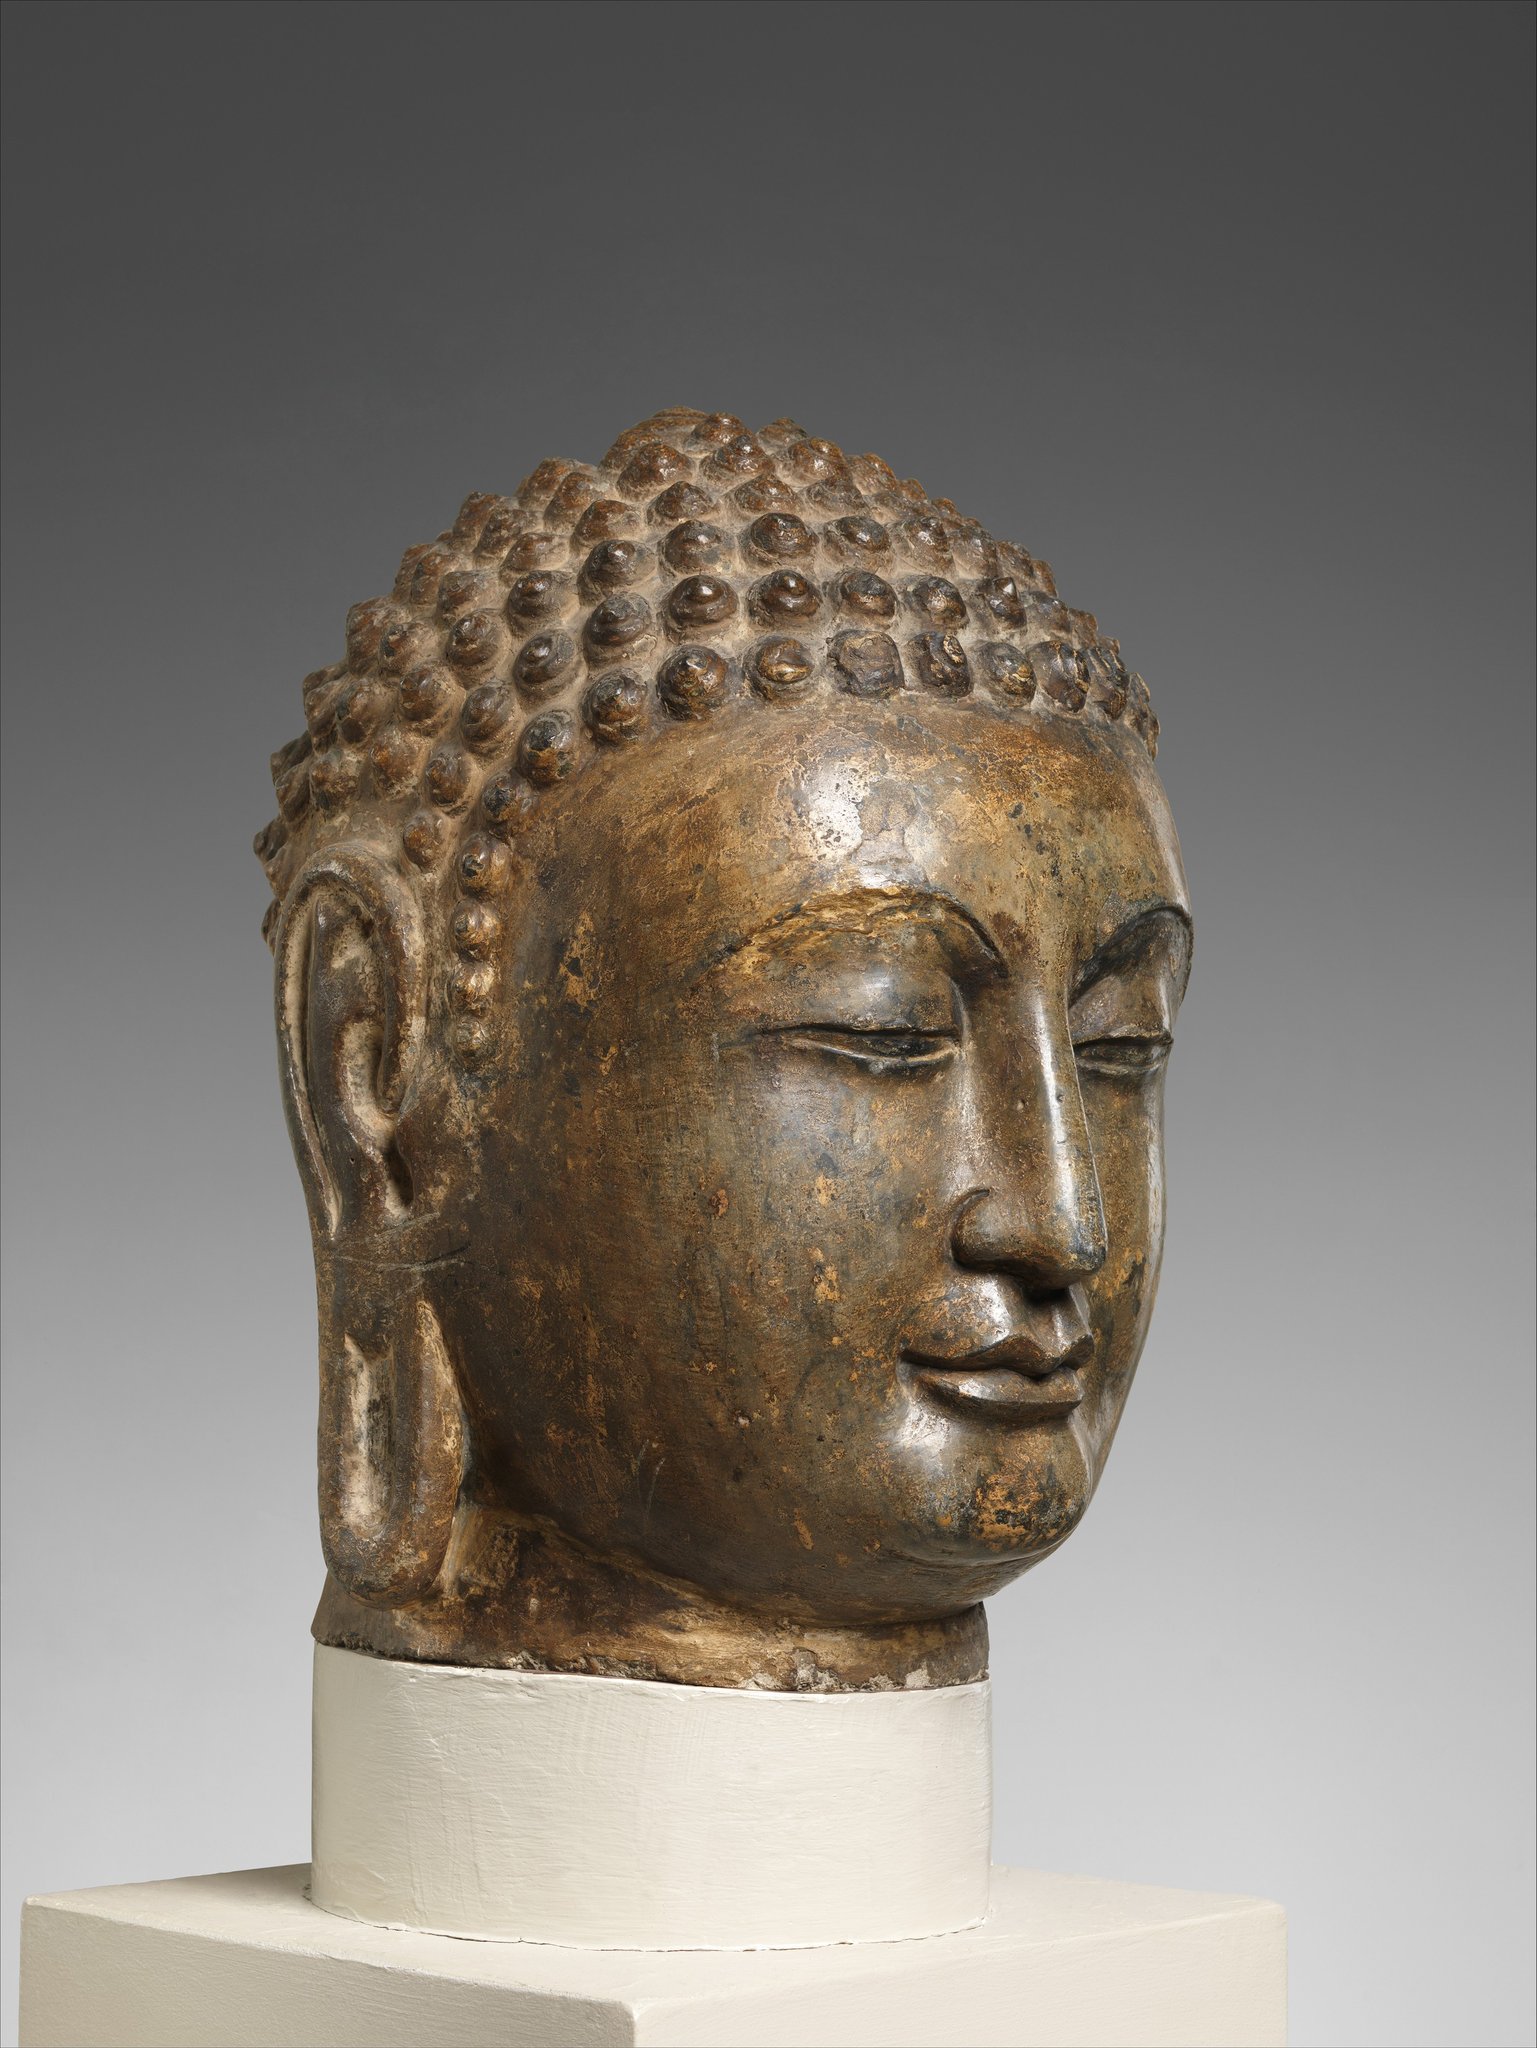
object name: head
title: Head of a Buddha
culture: chinese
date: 565-575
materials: limestone, pigment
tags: faces,heads,buddha